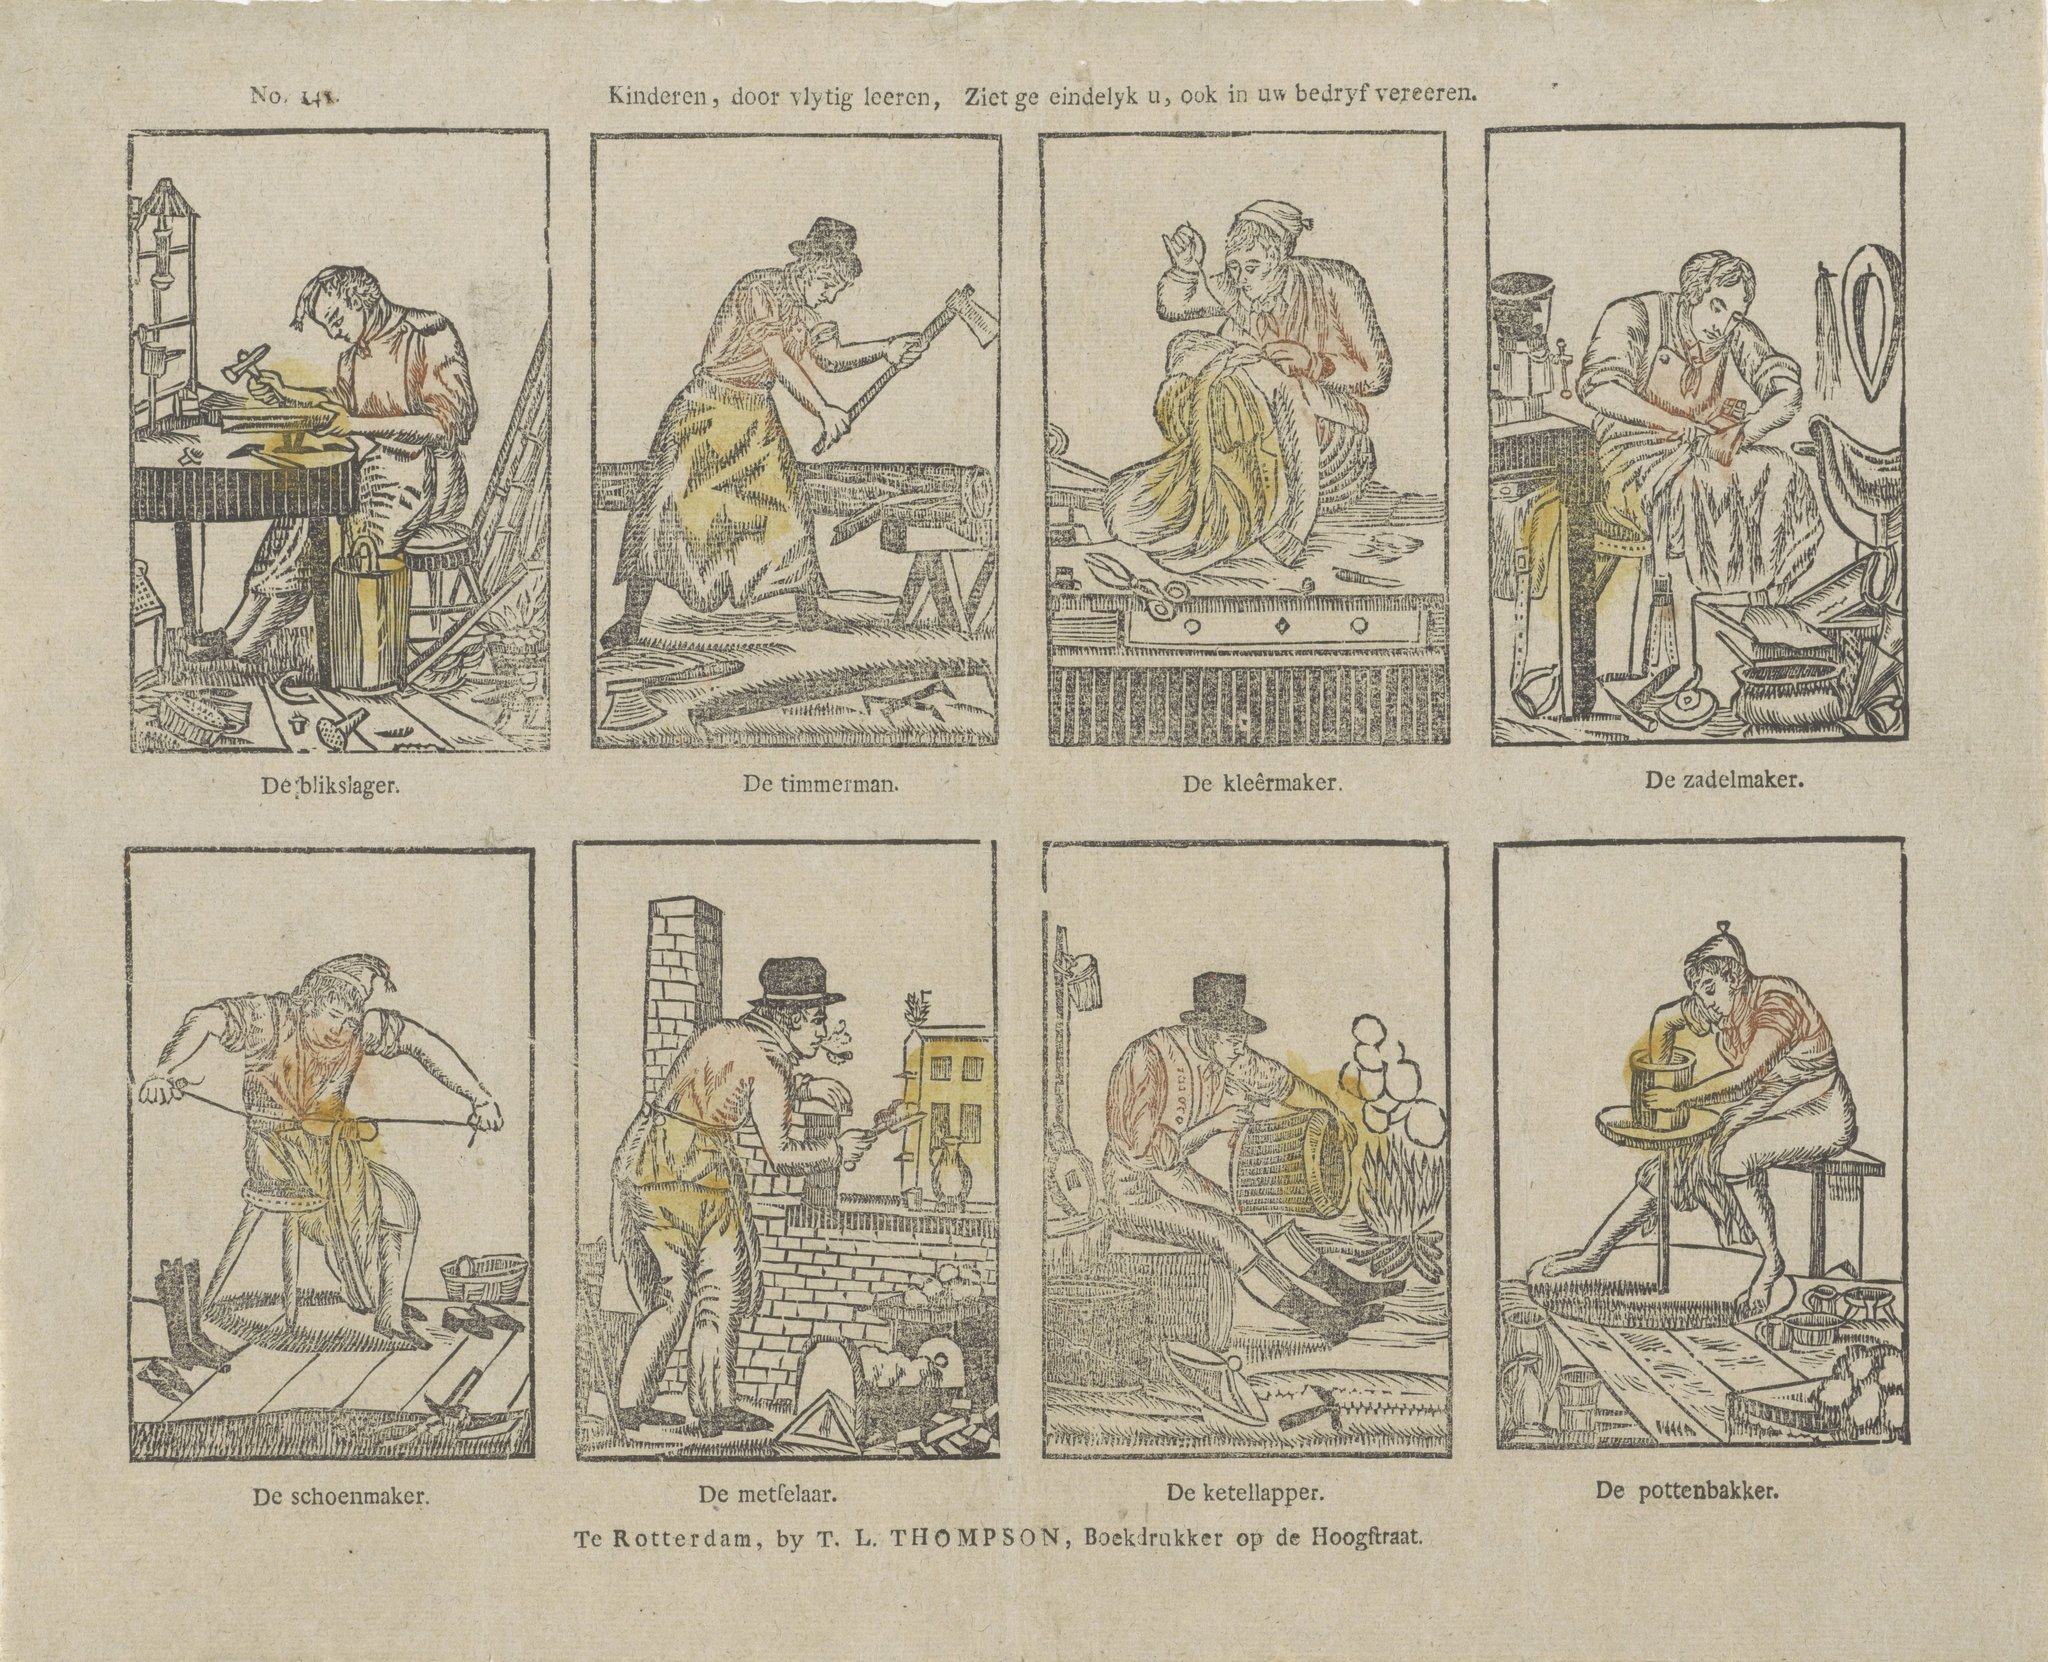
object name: print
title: Kinderen, door vlytig leeren, Ziet ge eindelyk u, ook in uw bedryf vereeren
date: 1825-1838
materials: paper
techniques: colour, letterpress printing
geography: rotterdam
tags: carpenter, craft-production, skilled handiwork, tailor, dressmaker, crafts and industries, potter, ceramist, shoe-maker, cobbler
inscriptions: collector's mark: Lugt 2760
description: Blad met 8 voorstellingen van ambachtslieden, zoals timmerman, kleermaker en pottenbakker. Onder elke afbeelding een onderschrift. Genummerd linksboven: No. 141.